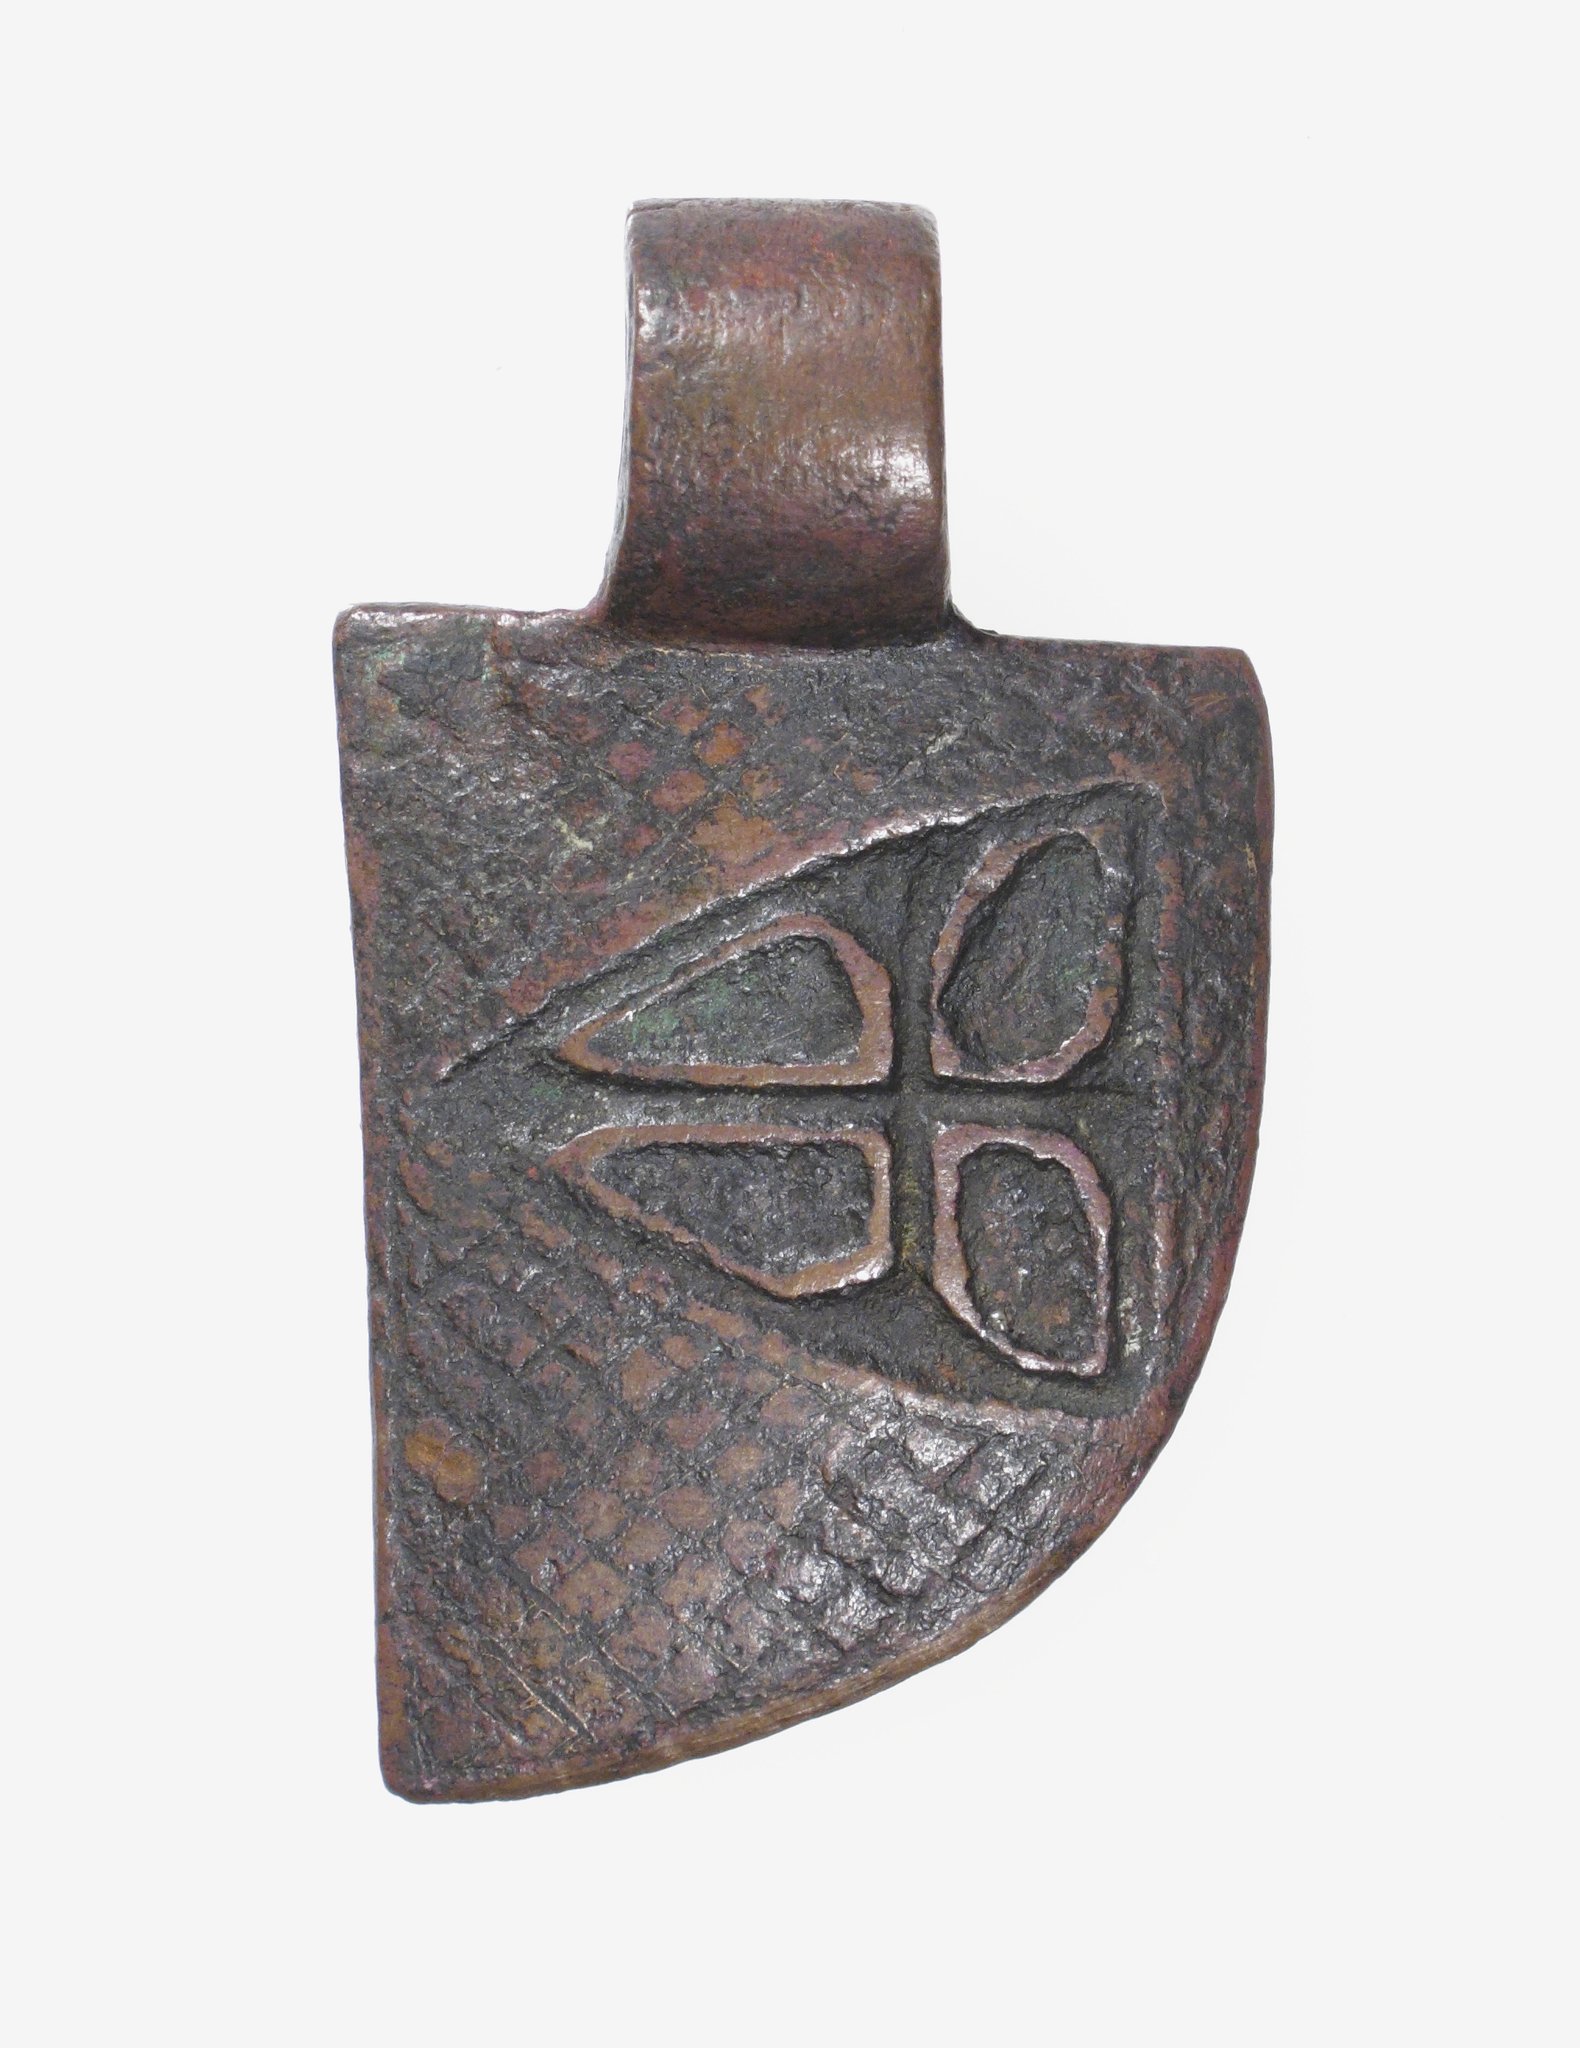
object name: horse trapping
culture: catalan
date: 1301-1500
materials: copper alloy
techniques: gilding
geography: spain